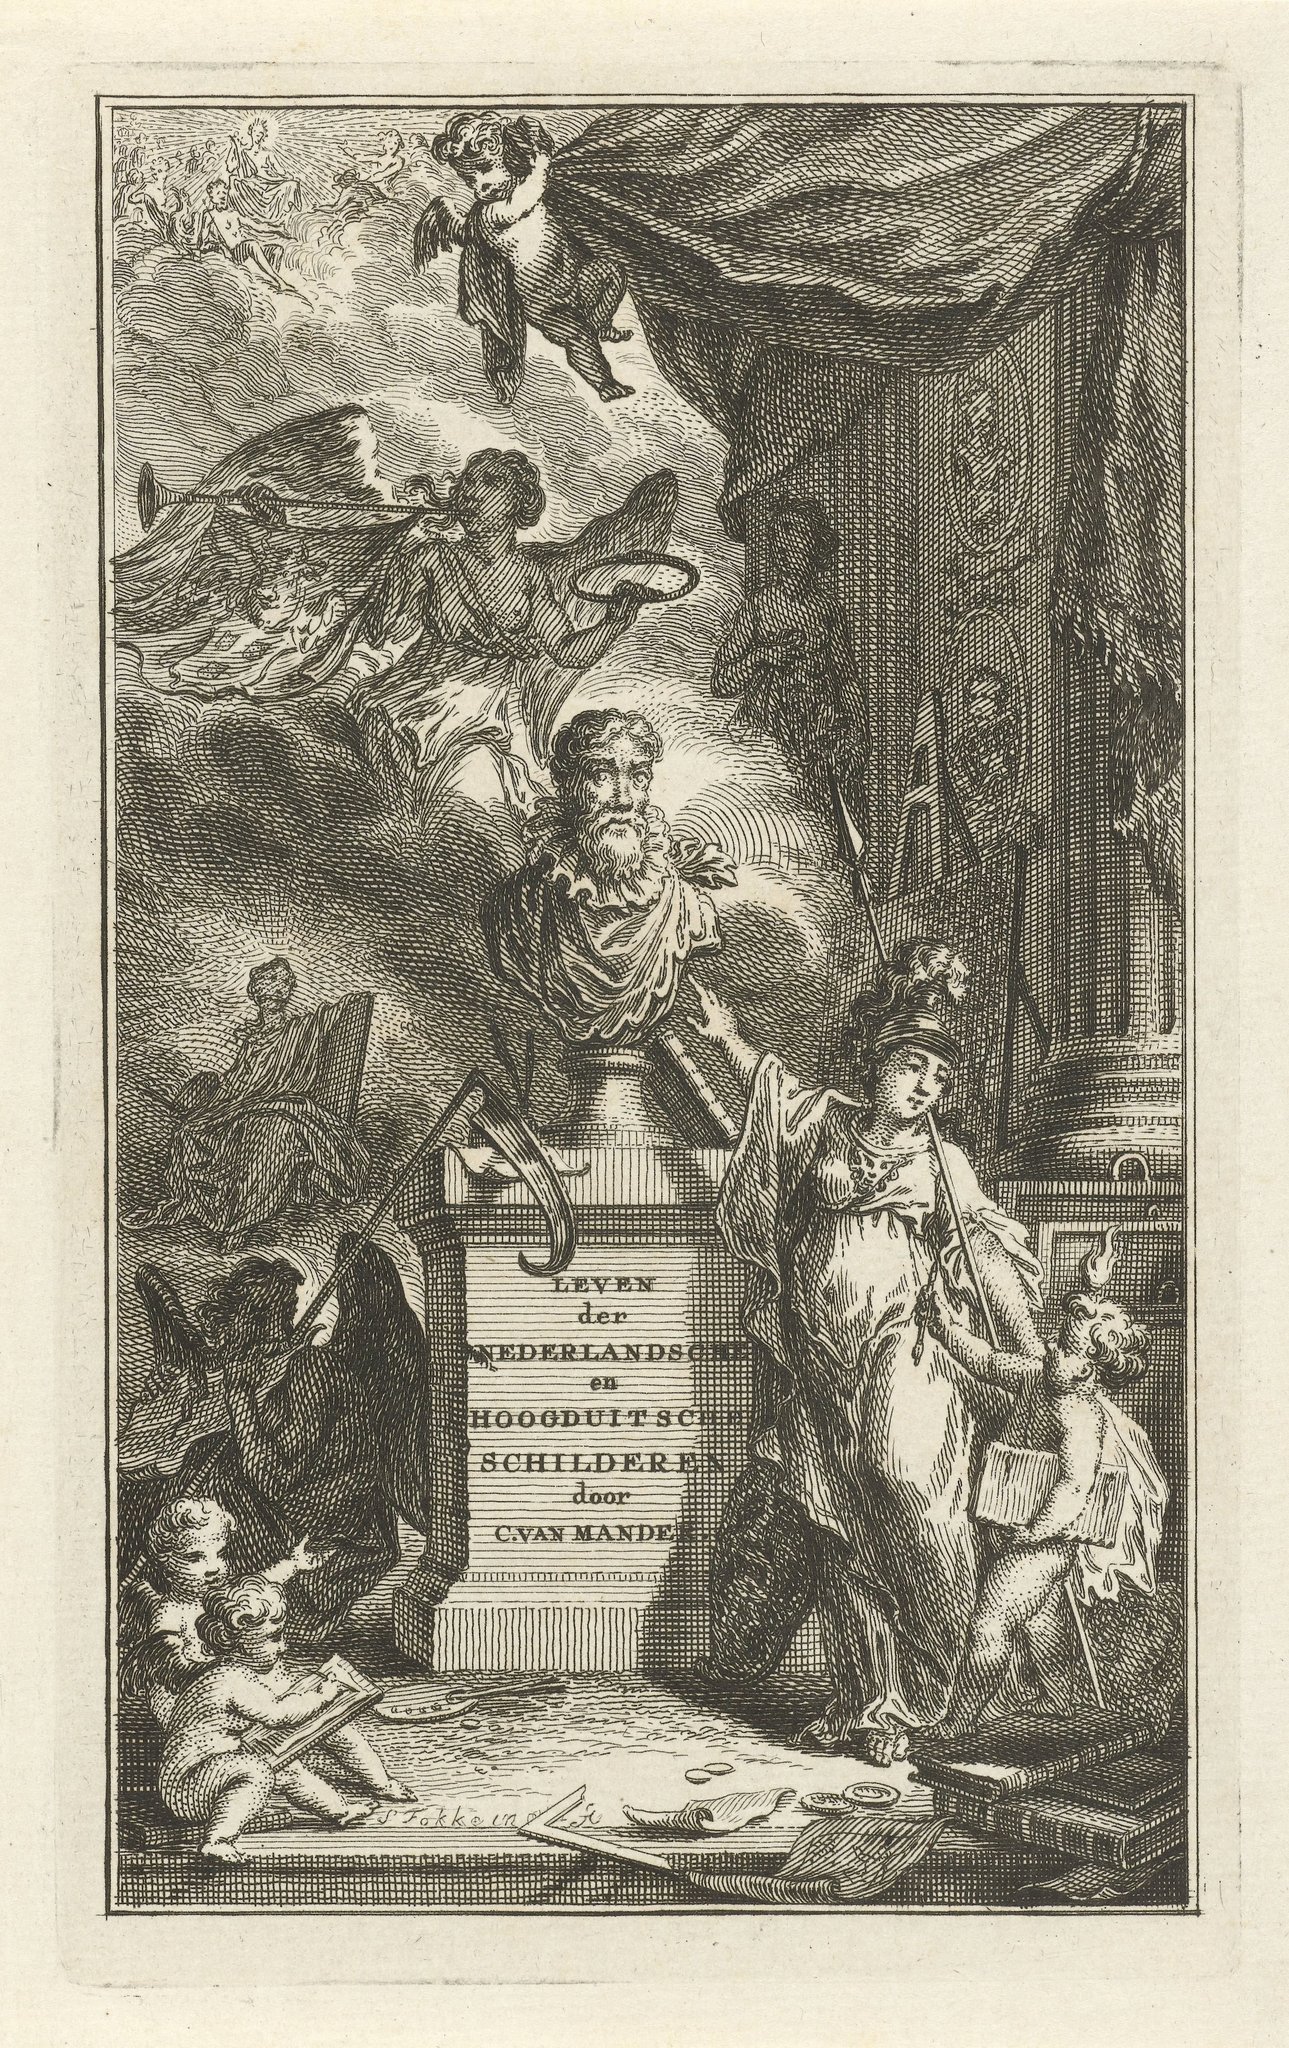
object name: print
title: Portret van Karel van Mander door putto geëerd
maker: simon fokke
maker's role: draughtsman, print maker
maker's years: 1712-1784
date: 1764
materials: paper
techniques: etching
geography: amsterdam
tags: amsterdam, painter, print maker, draughtsman, karel van mander (i), (story of) minerva (pallas, athena), serpent ouroboros, father time, man with wings and scythe, historical person (with name)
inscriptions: collector's mark: Lugt 2228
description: De portretbuste van Karel van Mander wordt door een bazuin blazende putto geëerd met het eeuwigheidssymbool, een slang die zich in eigen staart bijt. Naast de voet waar het beeld op staat, zit Vader Tijd met een zeis. Rechts wijst Minerva een putto op de buste van Van Mander.